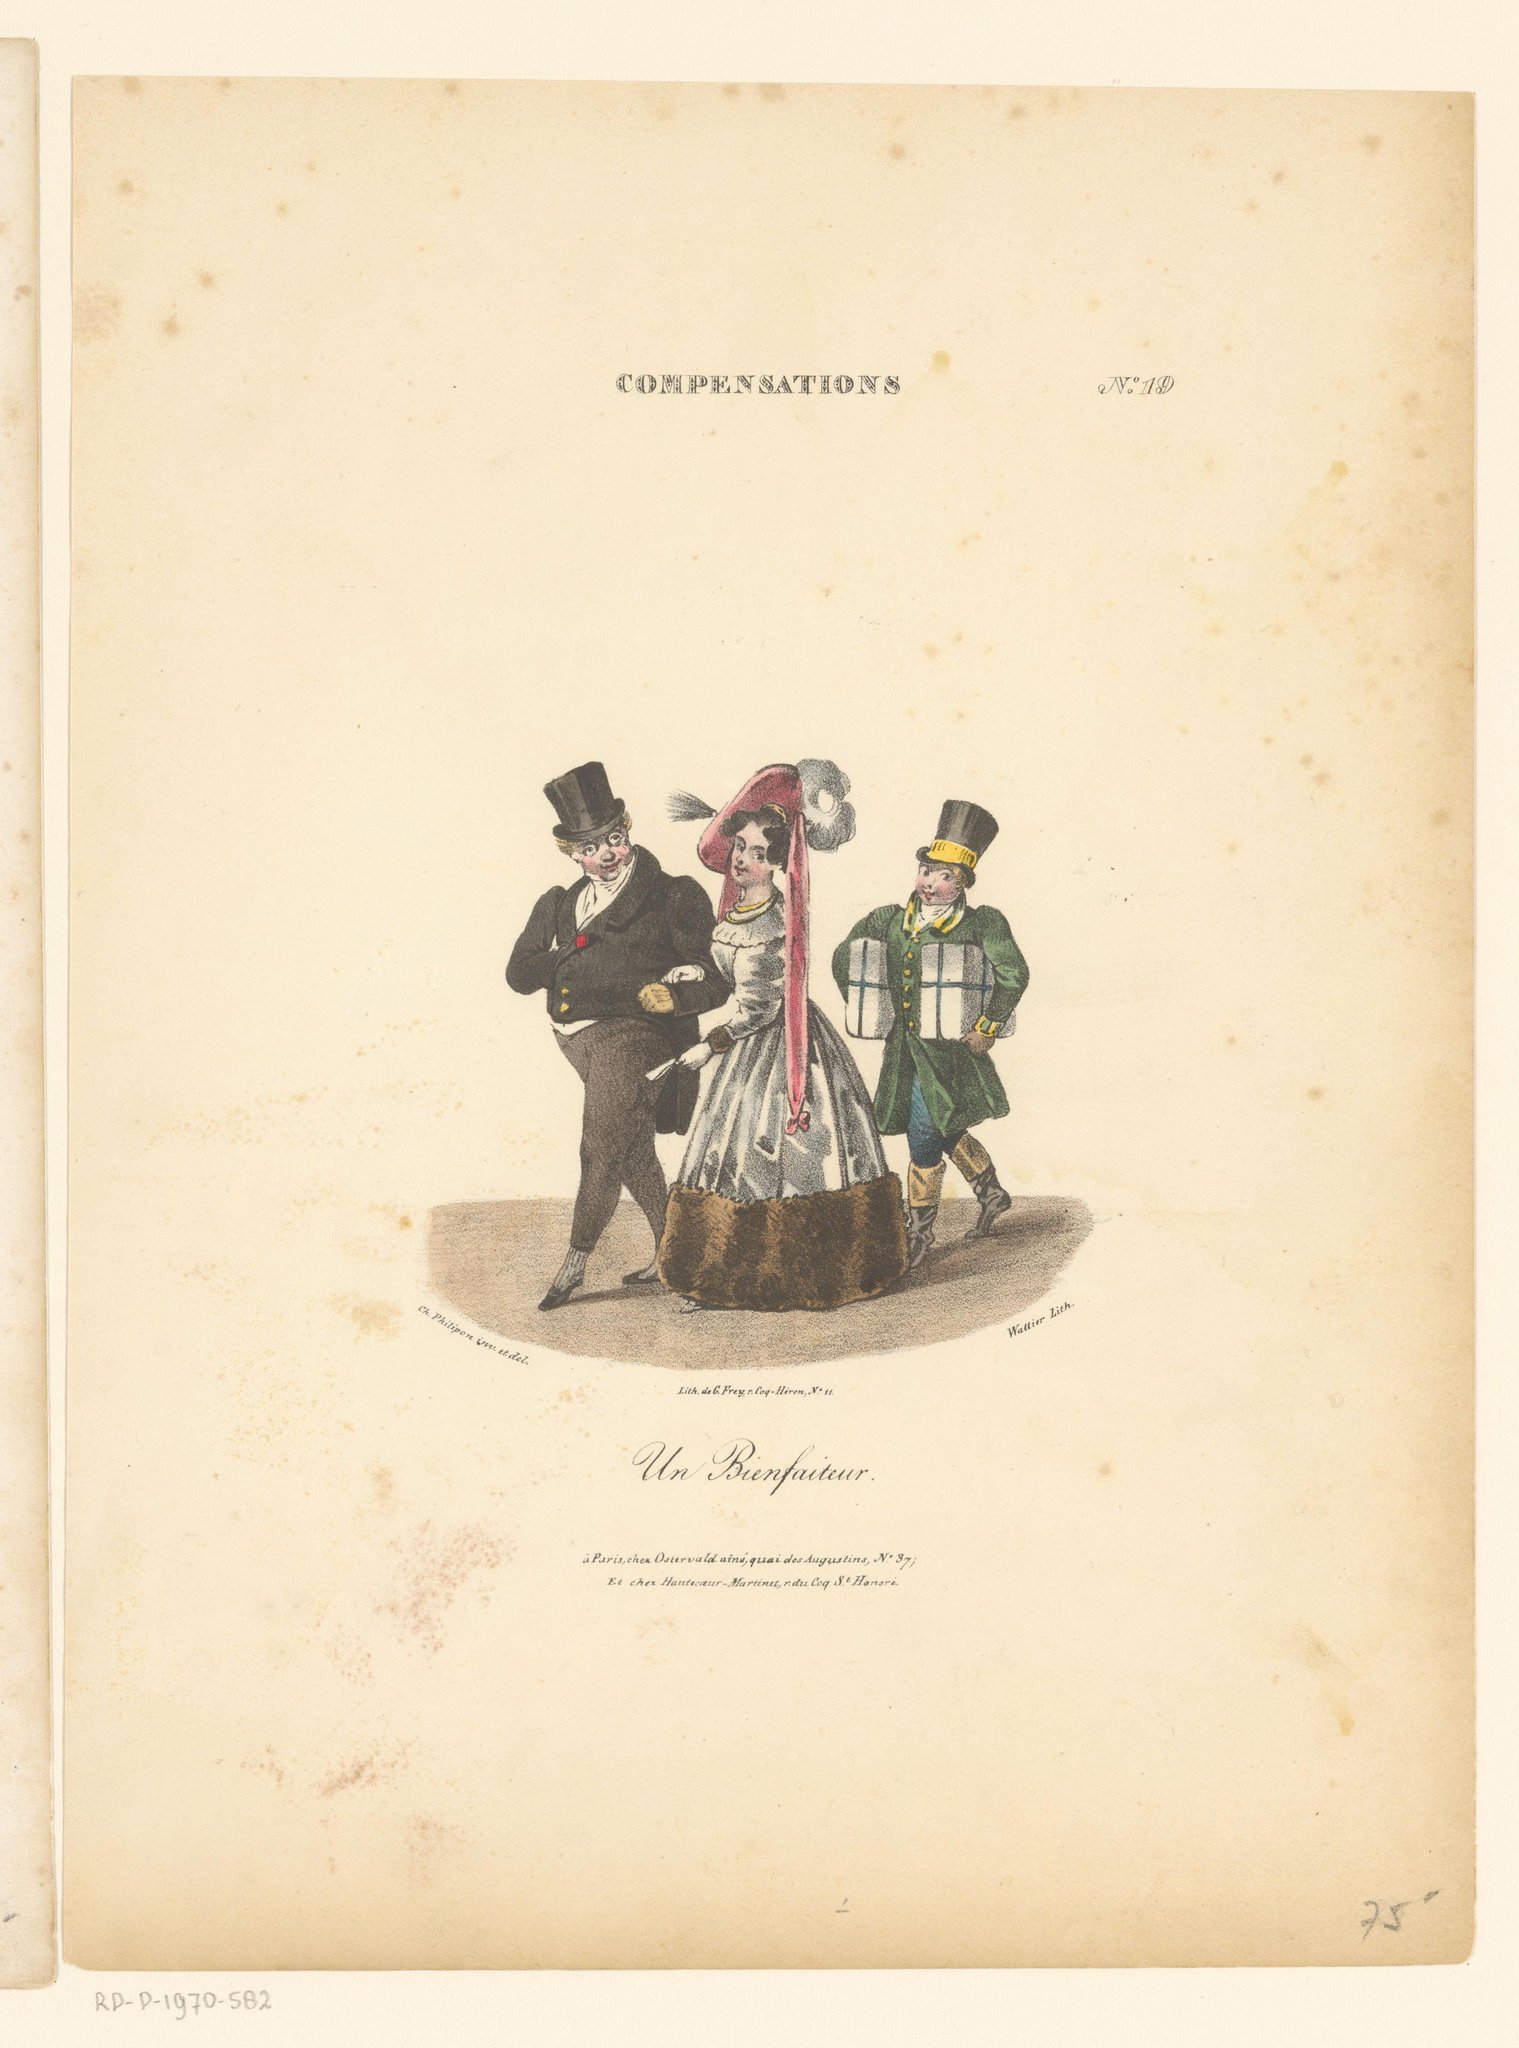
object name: print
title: Rijke man met vrouw aan de arm, daarachter man met aankopen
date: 1828-1830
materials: paper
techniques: hand coloring, lithograph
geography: paris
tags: adult woman, adult man, maid ~ house personnel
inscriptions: inscription: ‘Paul Prouté, 74 Rue de Seine/ 30 Dec. 1964. N.F. 2,- (3 stuks)’, collector's mark: Lugt 2228